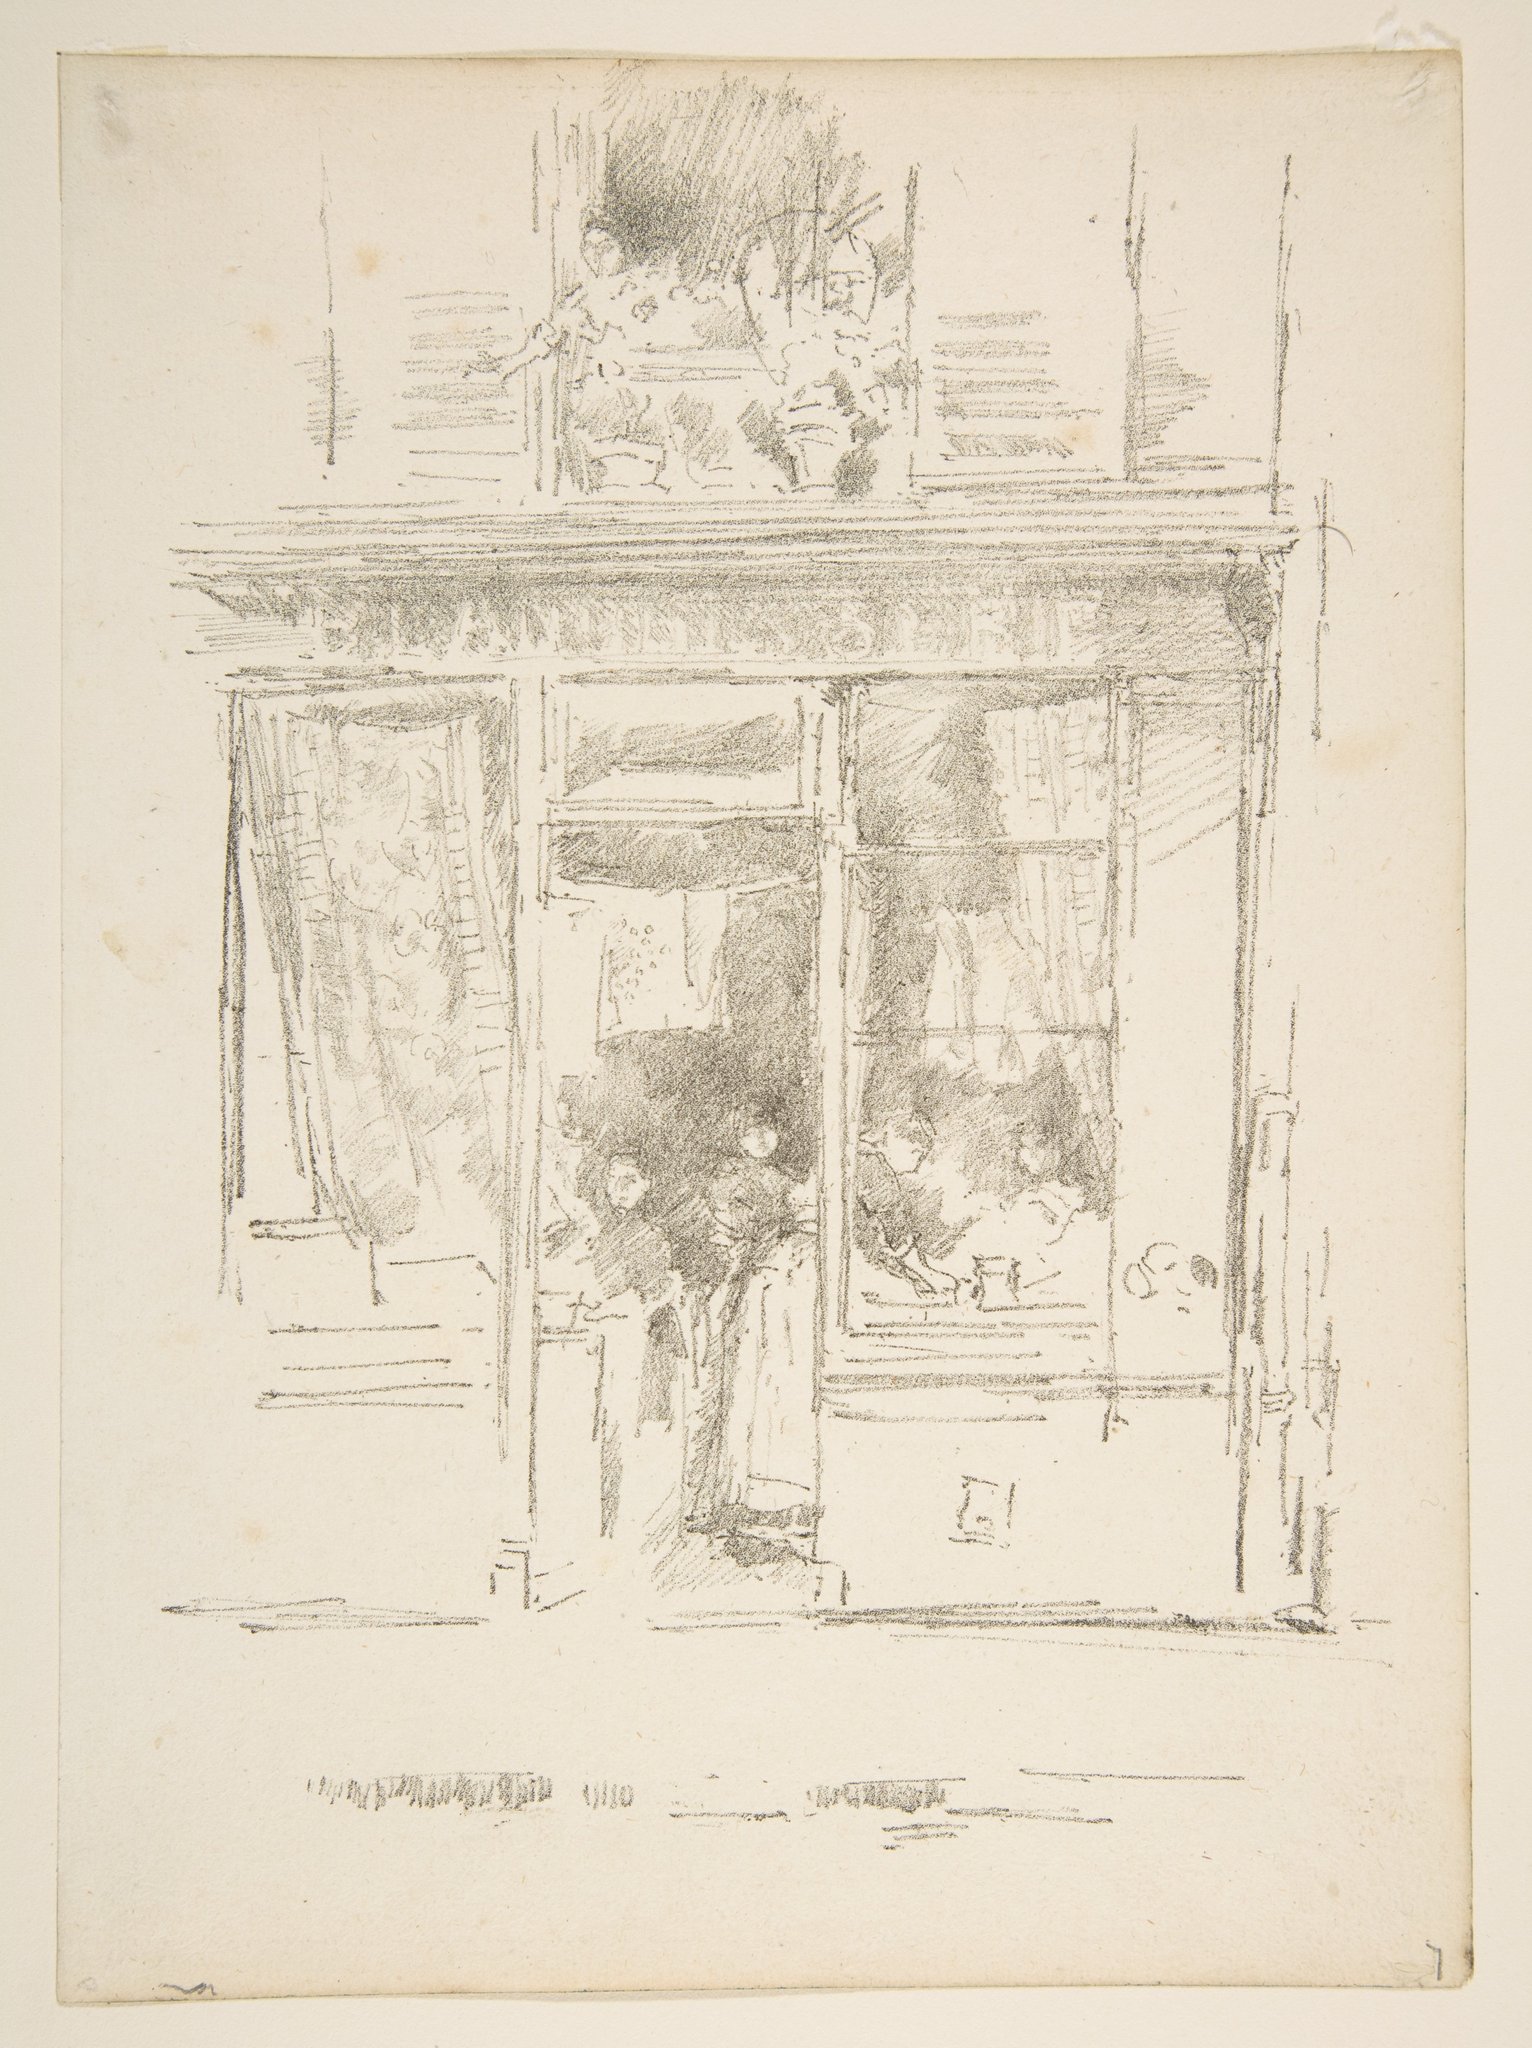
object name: print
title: The Laundress: "La Blanchisseuse de la Place Dauphine"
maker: james mcneill whistler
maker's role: artist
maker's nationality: american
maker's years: 1834-1903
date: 1894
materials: ink, paper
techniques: printing, lithography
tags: buildings